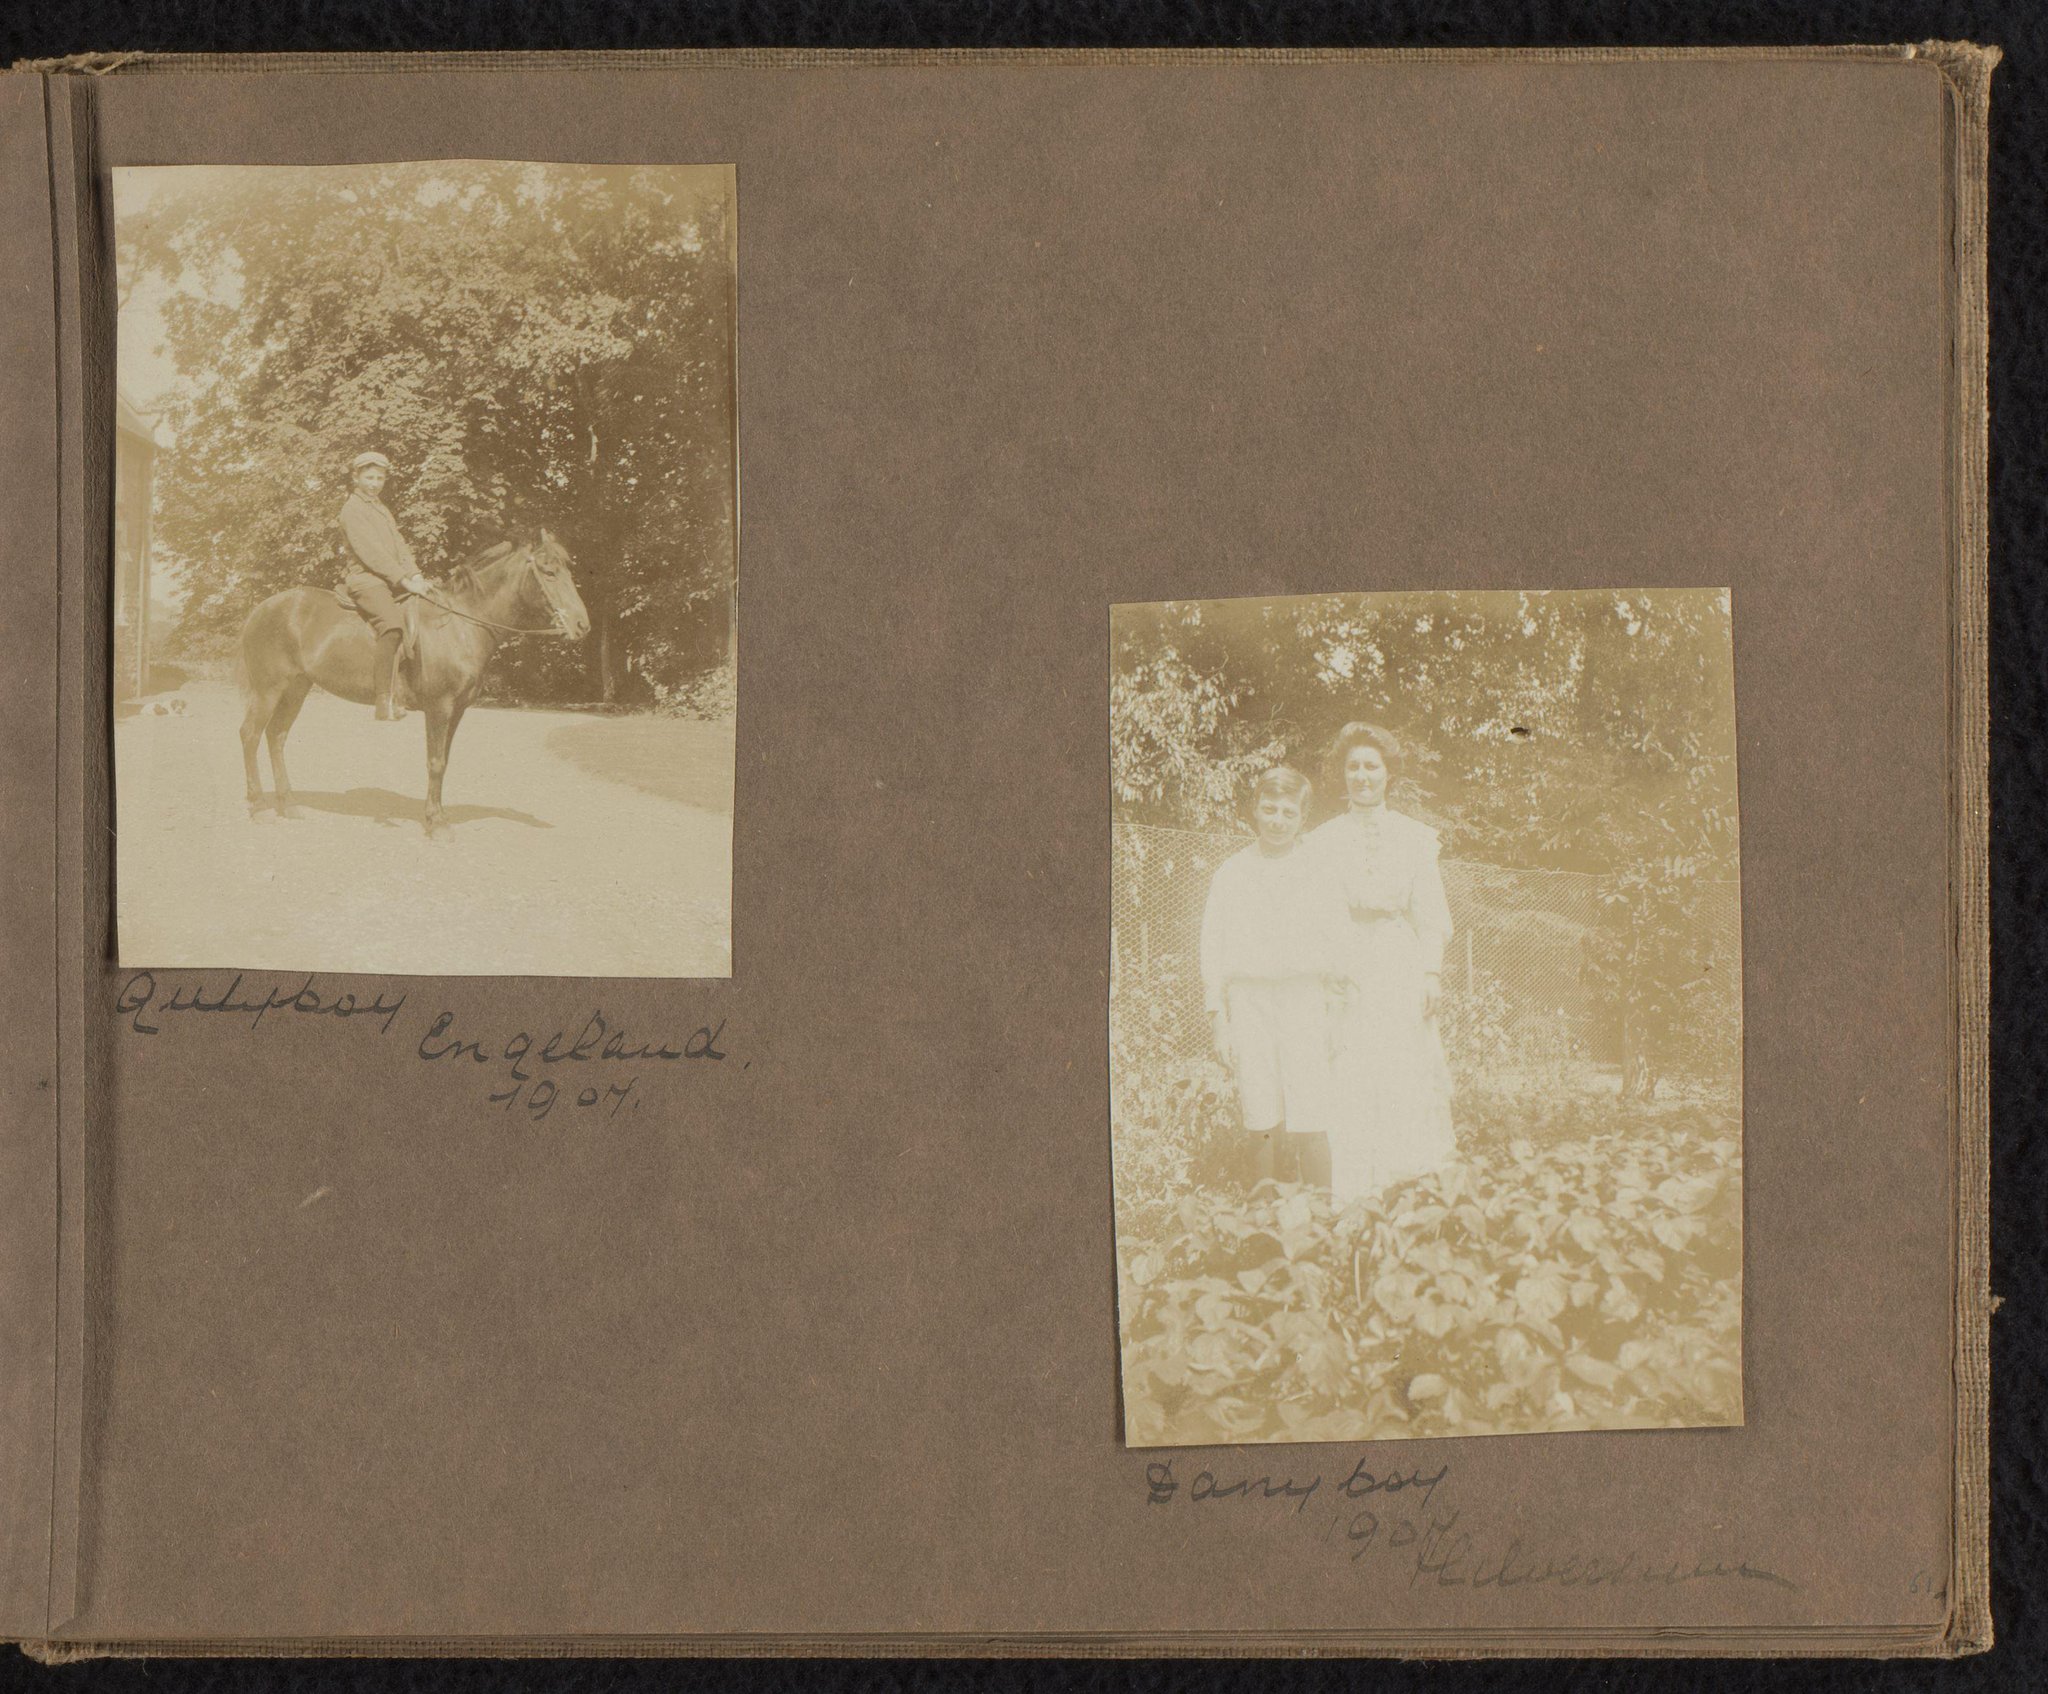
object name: photograph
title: Twee foto's van Guly Boissevain te paard en een jongen genoemd Dany met een vrouw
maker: Anonymous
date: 1907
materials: paper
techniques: gelatin silver print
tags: riding a horse, ass, or mule; rider, horseman, historical persons, england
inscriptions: inscription: ‘Gulyboy/ Engeland/ 1907’, inscription: ‘Dany boy/ 1907/ Hilversum’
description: Deze foto's maken deel uit van een album.